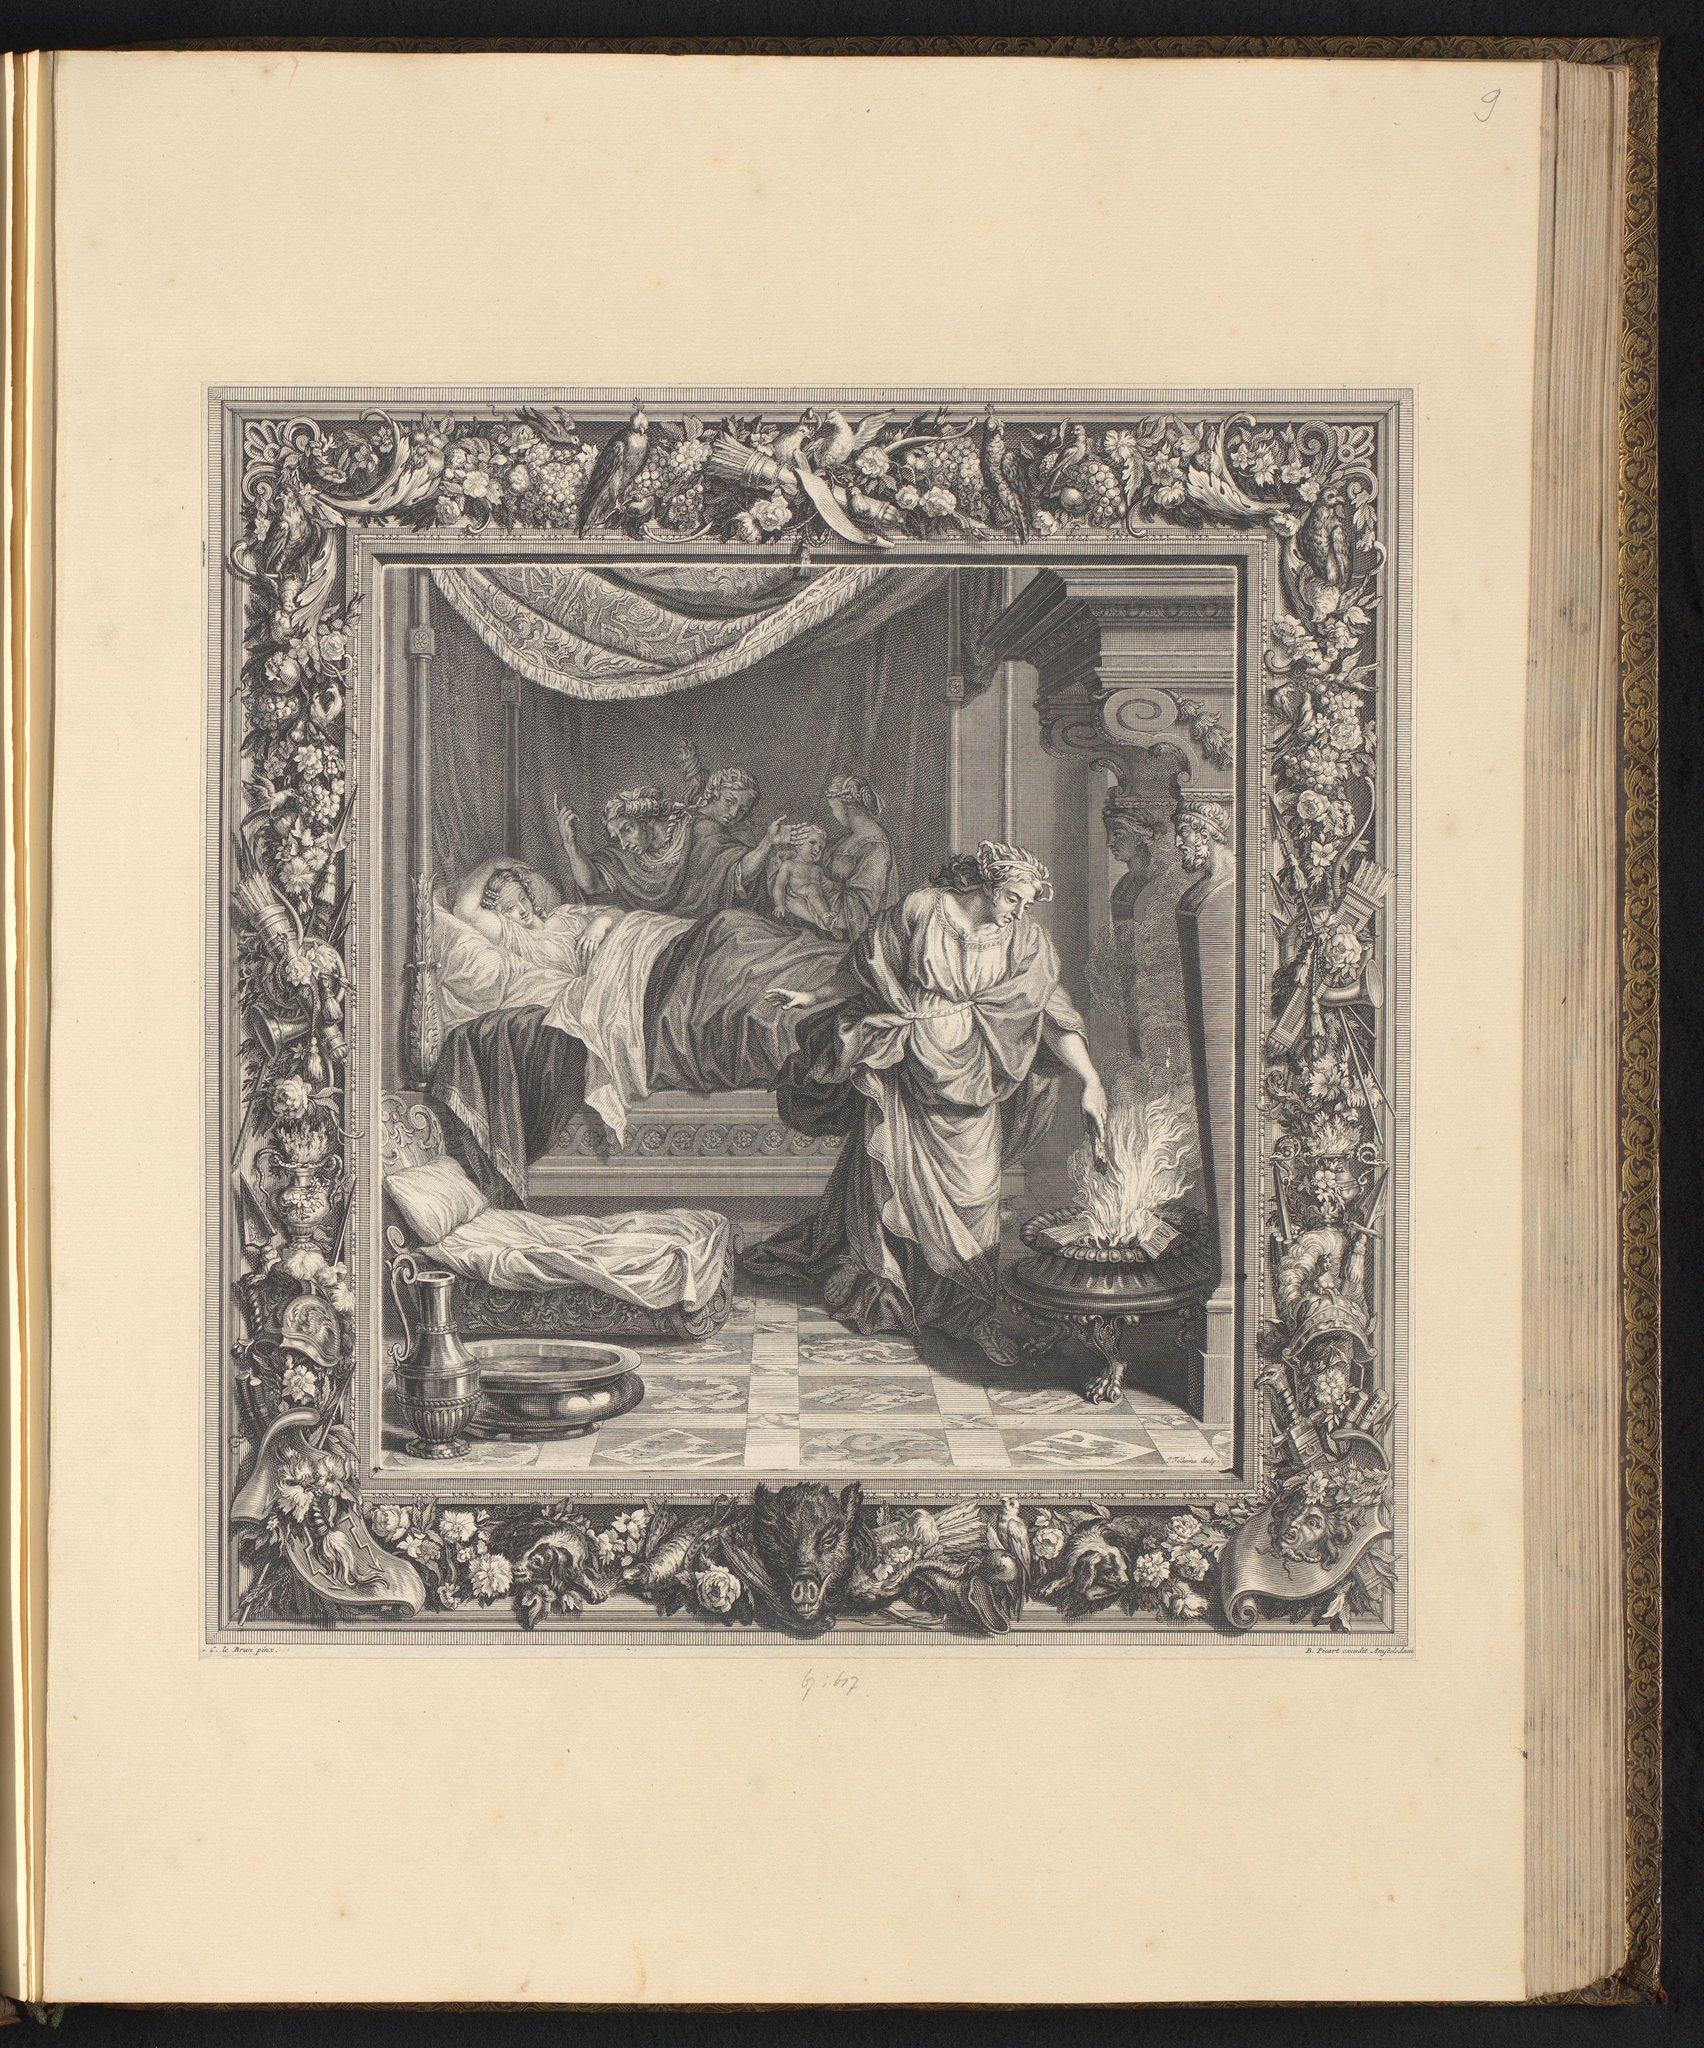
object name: album leaf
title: L'ouvrage de Charles le Brun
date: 1714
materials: paper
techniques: engraving, etching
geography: amsterdam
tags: birth of meleager: althaea, his mother, warned by a prediction of the fates, snatches a brand from the fire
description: Althaea ligt in bed met de Moirai aan haar zijde. Op de voorgrond steekt een bediende het blok hout in het vuur dat de lengte van het leven van Meleager zal bepalen. In een decoratieve rand met verwante thema's. Deze prent maakt deel uit van een album.